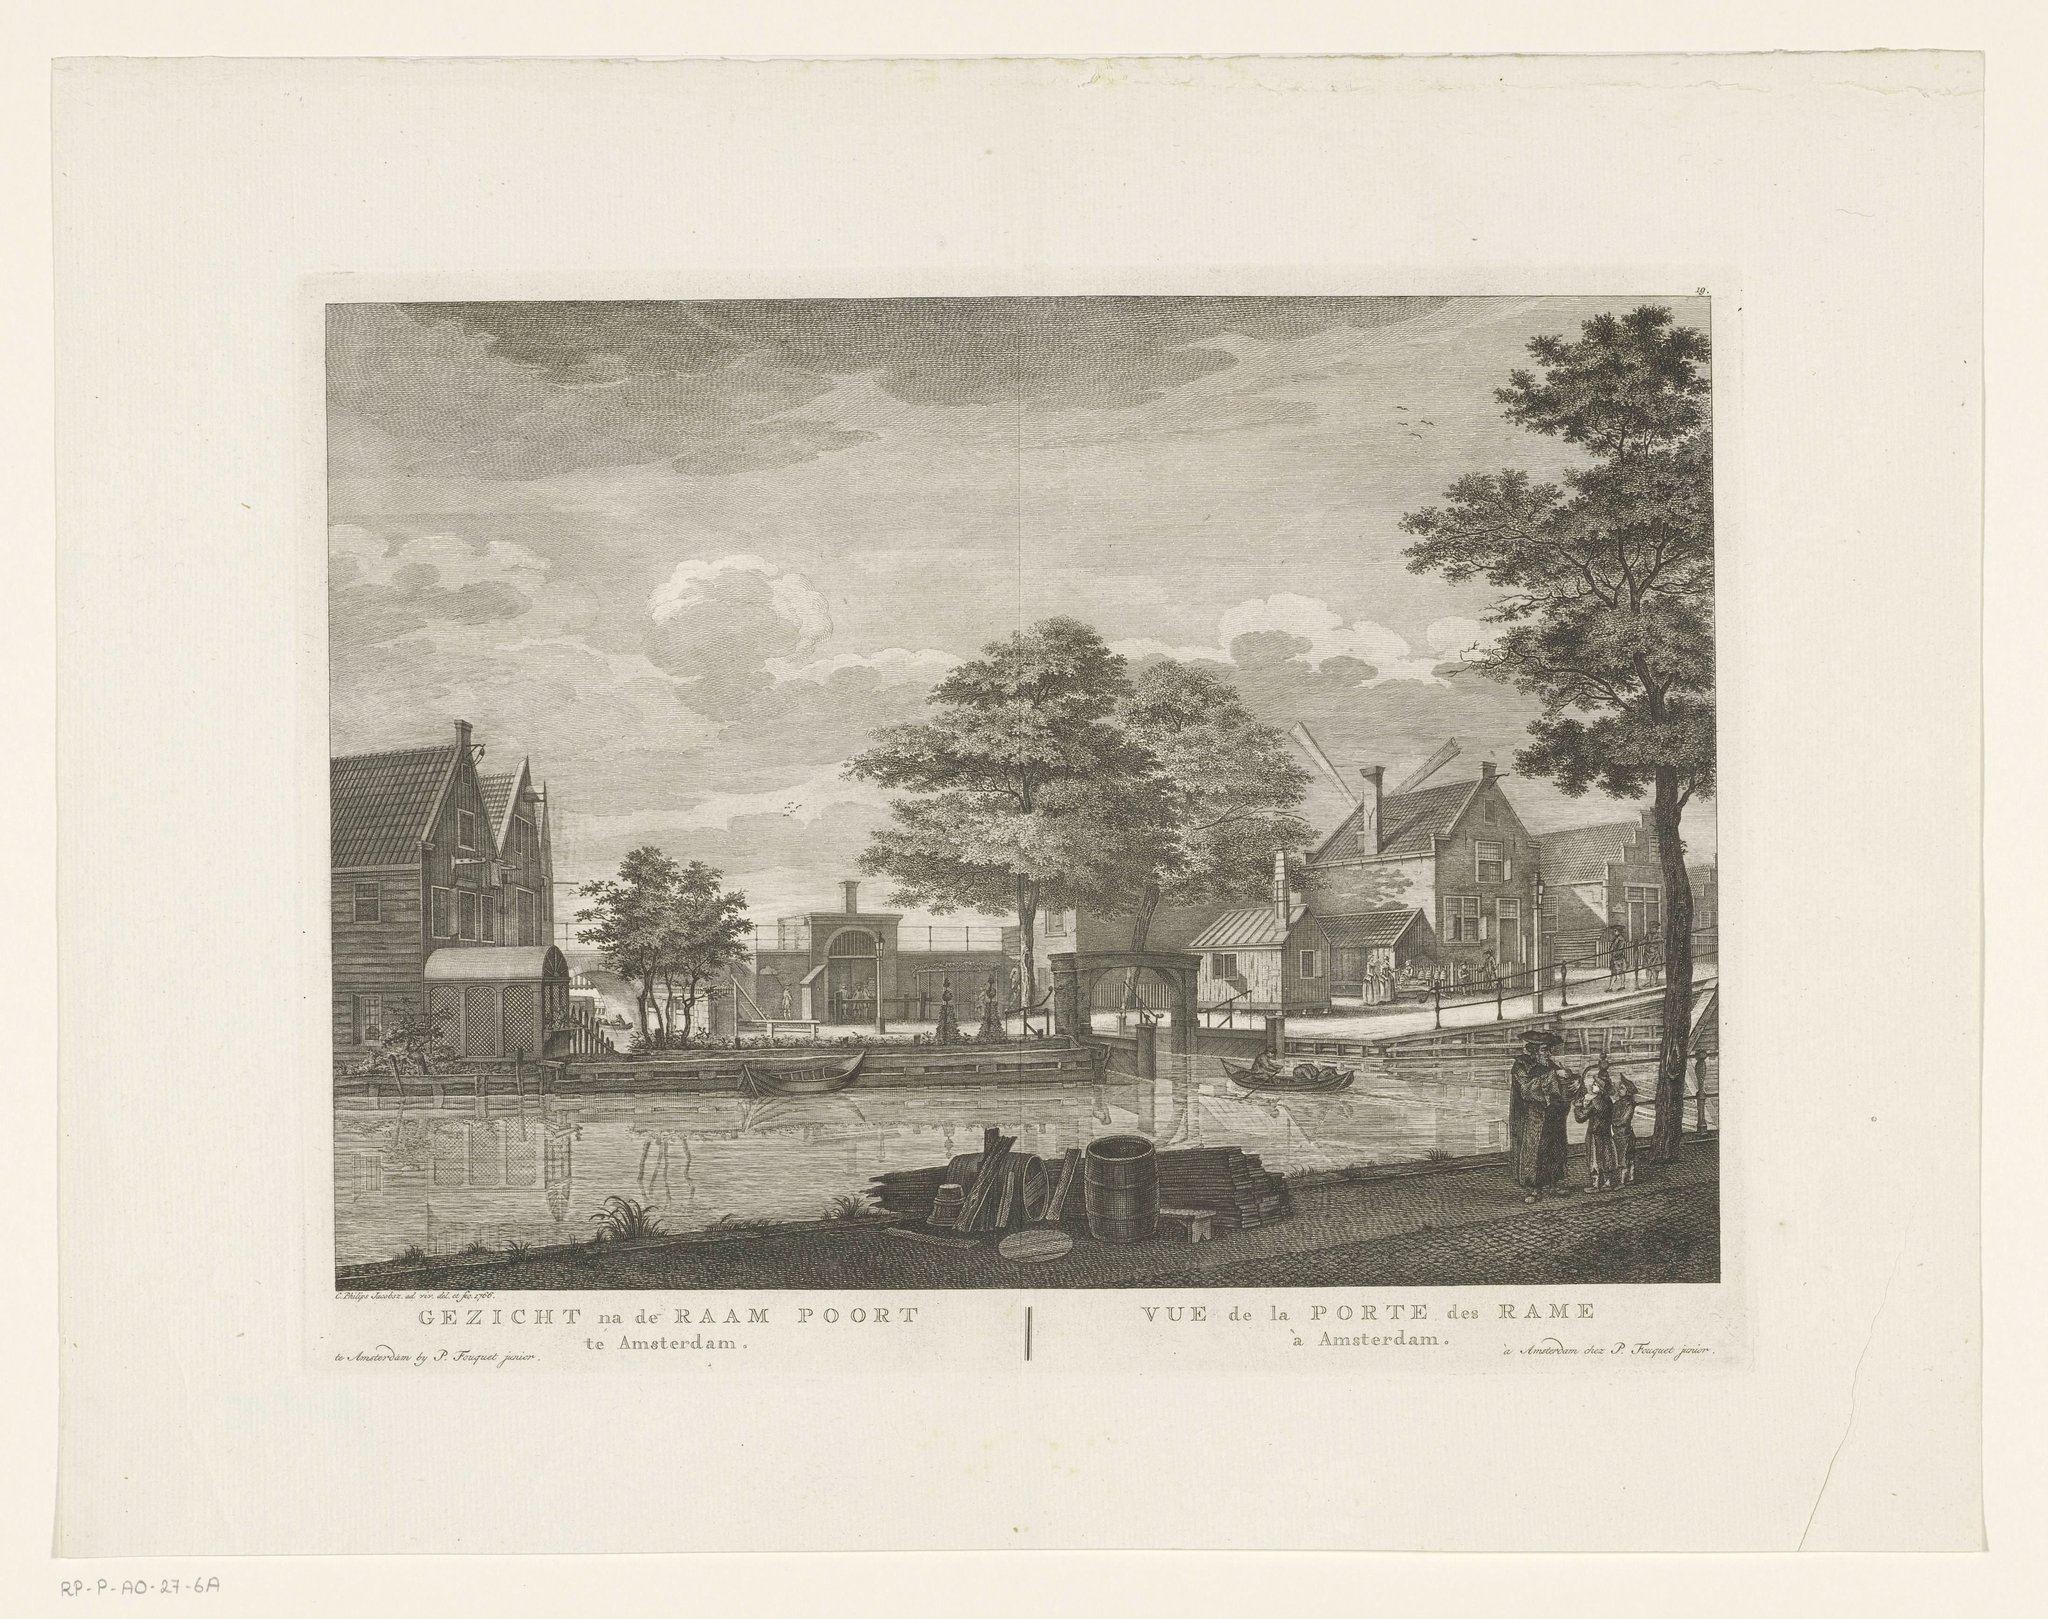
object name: print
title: Gezicht na de Raam Poort te Amsterdam / Vue de la Porte des Rame à Amsterdam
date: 1766-1783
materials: paper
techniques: engraving, etching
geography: amsterdam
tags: city-gate, canals, waters (in city) (+ city(-scape) with figures, staffage), street (+ city(-scape) with figures, staffage)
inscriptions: collector's mark: Lugt 2228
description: Deze prent is ook gebruikt in de zogenaamde Atlas van Fouquet.* Pierre Fouquet gaf vanaf 1760 stadsgezichten van Amsterdam - naar tekeningen van verschillende kunstenaars, gemaakt door verschillende prentmakers - uit. Deze prenten werden aanvankelijk los of in series verkocht. Zoals toen gebruikelijk kon de koper de prenten zelf laten inbinden. Hiertoe gaf Fouquet tussen 1778 en 1783 een titelblad, plattegrond en inhoudsopgave van de tot dusver 100 uitgegeven prenten uit (1). Gezien de inhoud afhankelijk was van wat de koper had verzameld verschilt de inhoud van de verschillende bewaarde Fouquetatlassen onder deze titel sterk. Ook zijn er exemplaren bekend waar tevens andere prenten aan zijn toegevoegd. Omdat er behoefte bleek aan uitleg bij de platen werd in 1783 een nieuwe versie van de atlas uitgegeven, aangevuld met tekst en twee prenten. De aangegeven volgorde veranderde maar de platen van de al eerder uitgegeven prenten bleven ongewijzigd. Deze uitgave werd in opdracht van Fouquet gedrukt bij Daniël Jean Changuion en Petrus den Hengst (2). Een tiental platen werd bijgewerkt en verscheen, met nieuw impressum, in het vervolg van Wagenaars geschiedenis van Amsterdam, uitgeven door Petrus Conradi en Folkert van der Plaats (3). Een aantal jaar na het overlijden van Fouquet kwam Evert Maaskamp met een nieuwe uitgave van de atlas, met verbeterde tekst en toevoeging van twee prenten. Op alle platen verwijderde hij het oude en liet hij zijn eigen impressum zetten (4). De huidige staat van de prent komt voor in exemplaren van de onder (1) en (2) genoemde werken. * Onder de Atlas van Fouquet of Fouquetatlas verstaan we de hieronder vermelde publicaties (1), (2) en (4). (1). Afbeeldingen van de wyd-vermaarde koopstad Amsterdam benevens des zelvs voornaamste gebouwen en gezigten alle naar het leeven getekend / Receuil des edifices les plus considerables et des plus belles vues, de la fameuse ville d'Amsterdam, dessinées d'après nature. Amsterdam: Pierre Fouquet, 1778-1783. (2). Nieuwe atlas, van de voornaamste gebouwen en gezigten der stad Amsterdam, met derzelver beknopte beschryvingen. 2 delen. Amsterdam: Daniël Jean Changuion en Petrus den Hengst [in opdracht van Pierre Fouquet], 1783. (3). Stijl, Simon. Amsterdam, in zyne geschiedenissen, voorregten, koophandel, gebouwen, kerkenstaat, schoolen, schutterye, gilden en regeeringe, beschreeven. Om te dienen ten vervolge op het werk van Jan Wagenaar (…). 10 delen. Amsterdam en Harlingen: Petrus Conradi en Folkert van der Plaats, 1788-1801. (4). Nieuwe atlas, van de voornaamste gebouwen en gezigten der stad Amsterdam. Met derzelver beknopte beschryvingen. Amsterdam: Evert Maaskamp, 1805. * Het aantal vermelde staten is gebaseerd op het aantal gevonden staten. Mogelijk zijn er meer staten van deze prent. Voor eerste bekende staat zie RP-P-1905-573.